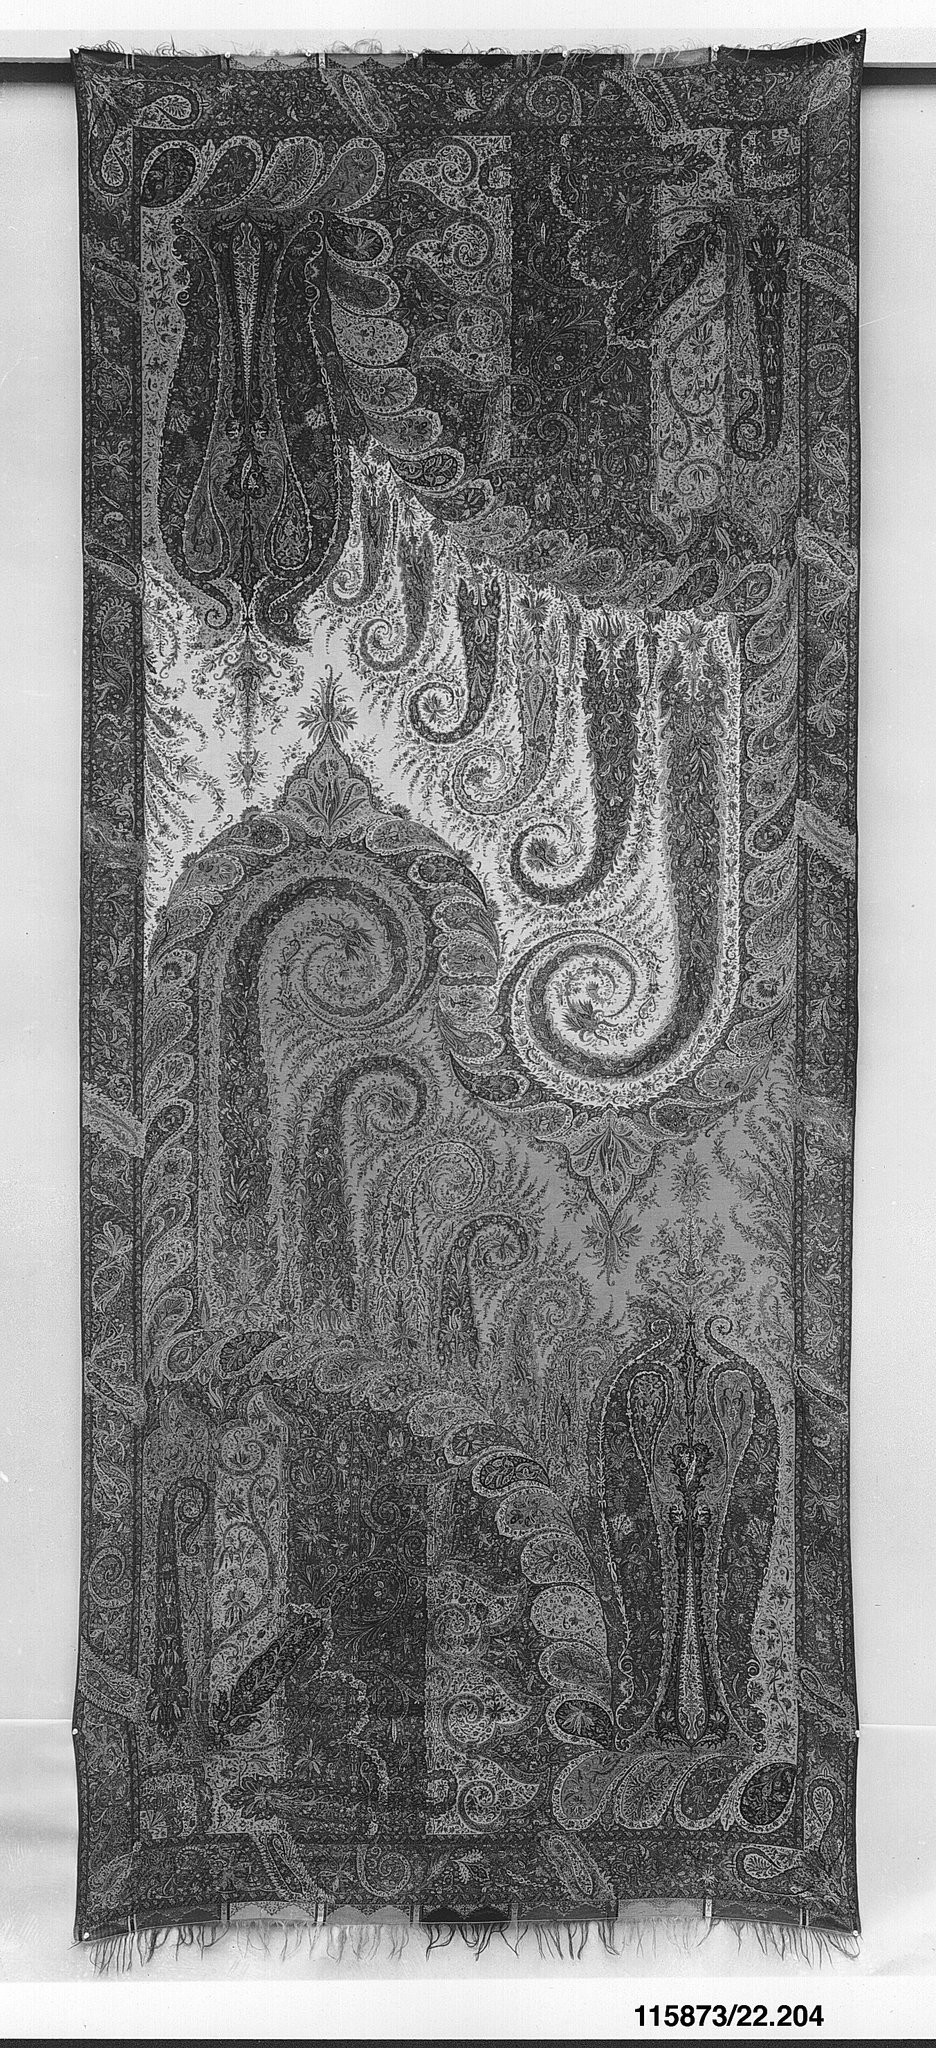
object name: shawl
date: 1834-1866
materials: silk, wool